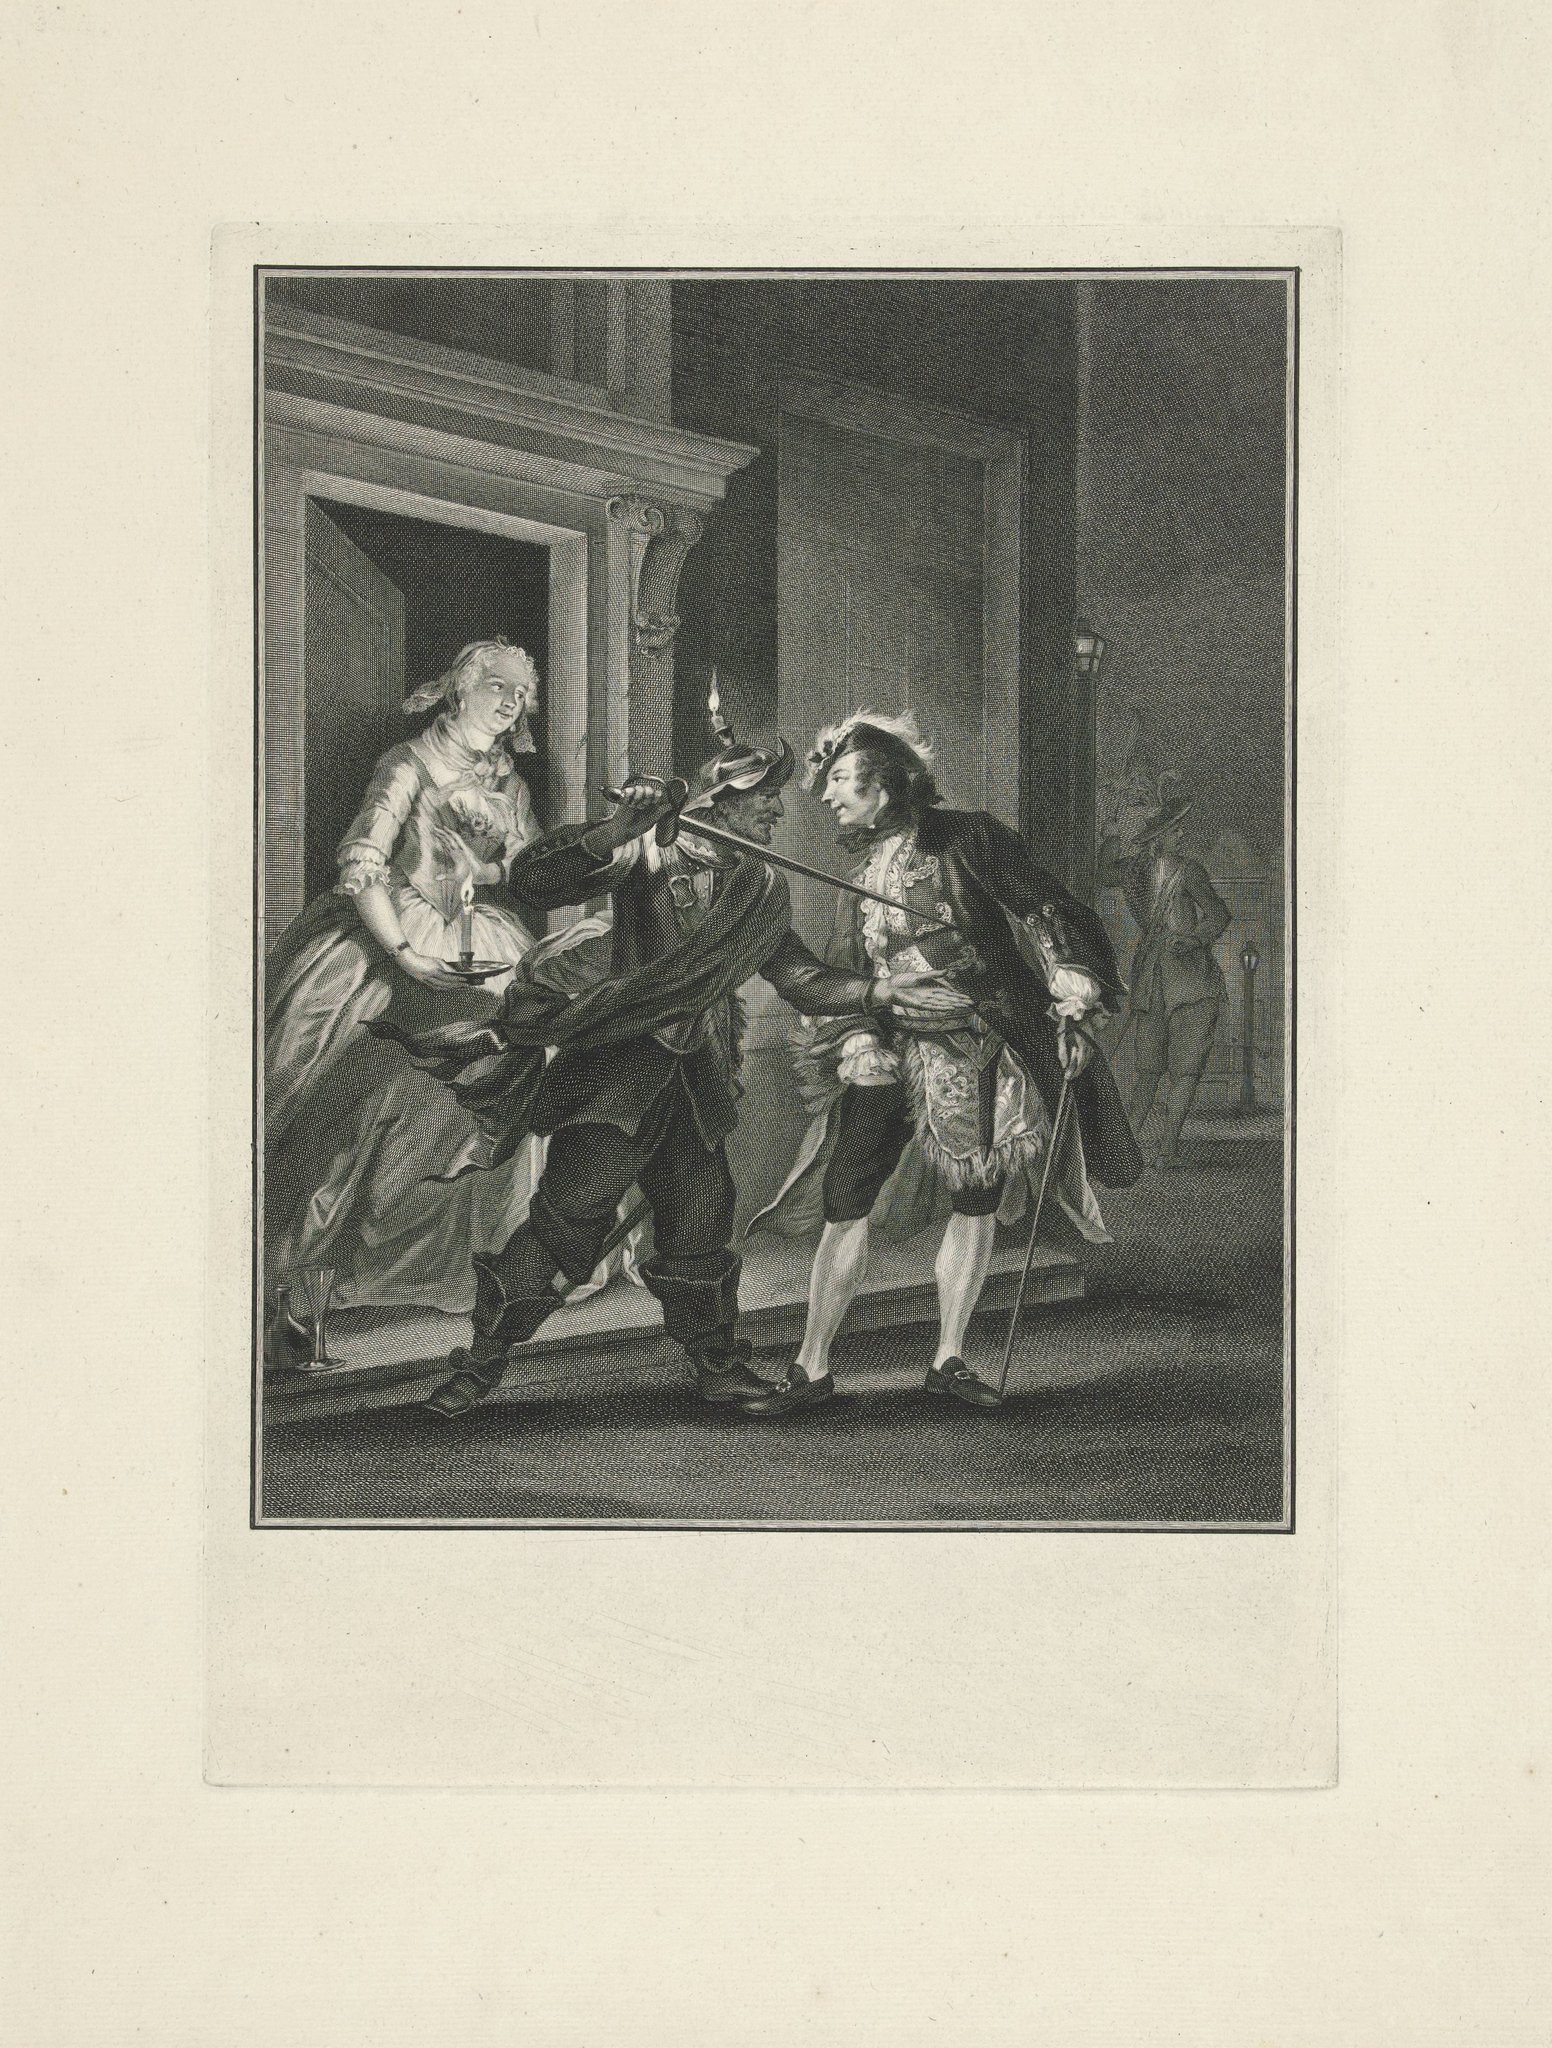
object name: print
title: Hopman Ulrich of de bedrogen gierigheid: de omkoping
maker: jacob houbraken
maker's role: draughtsman, print maker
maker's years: 1698-1780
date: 1760-1780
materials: paper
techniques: engraving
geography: amsterdam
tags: comedy, candlestick, guard duty, keeping sentry, night, bribery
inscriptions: collector's mark: Lugt 240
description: Een wachter met een zwaard vraagt een jongeman (Godefroy), die heimelijk in de nacht bij zijn geliefde (Sybille) op bezoek komt, om geld. De jongeman steekt zijn hand in zijn broekzak. De vrouw heeft een kaars vast. Op de stoep staan een glas en een fles. Rechts op de achtergrond een tweede wachter. Scène uit het blijspel 'Hopman Ulrich of de bedrogen gierigheid' van Johan van Paffenrode uit 1661, waarin het gierige personage Ulrich wordt bedrogen door zijn vrouw Sybille, ondanks dat hij haar laat bewaken. Haar minnaar Godefroy koopt de wachter om.